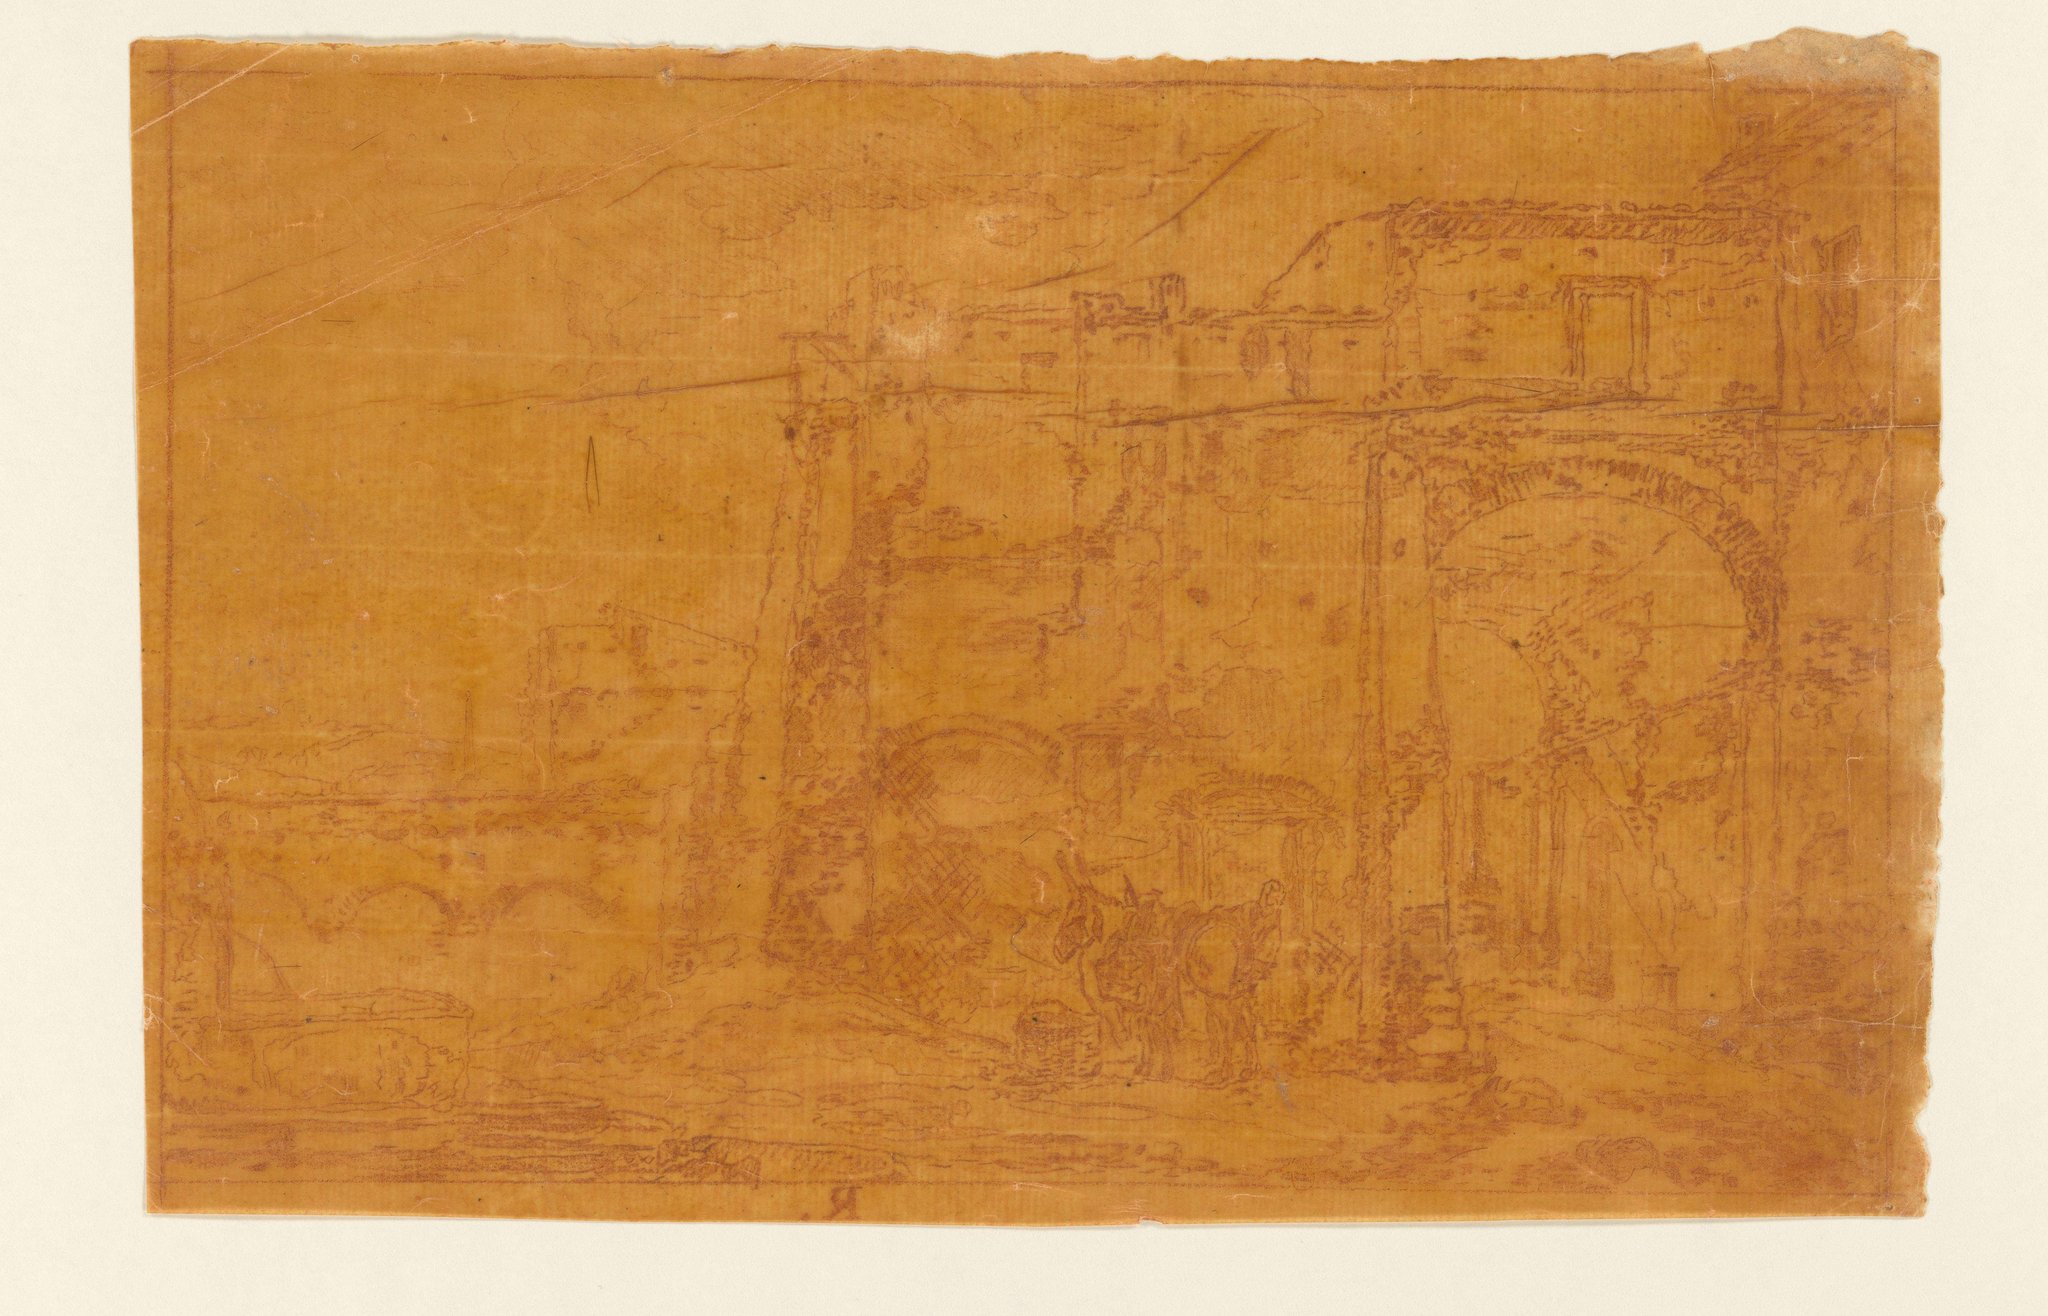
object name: tracing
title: Poort met reiziger en muildier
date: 1781-1782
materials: chalk, paper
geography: amsterdam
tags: city-view, and landscape with man-made constructions, mule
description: Bij een poort staan een man en een muildier. Rechts een waterbron. De calque ligt los in een album, zie blad 35.